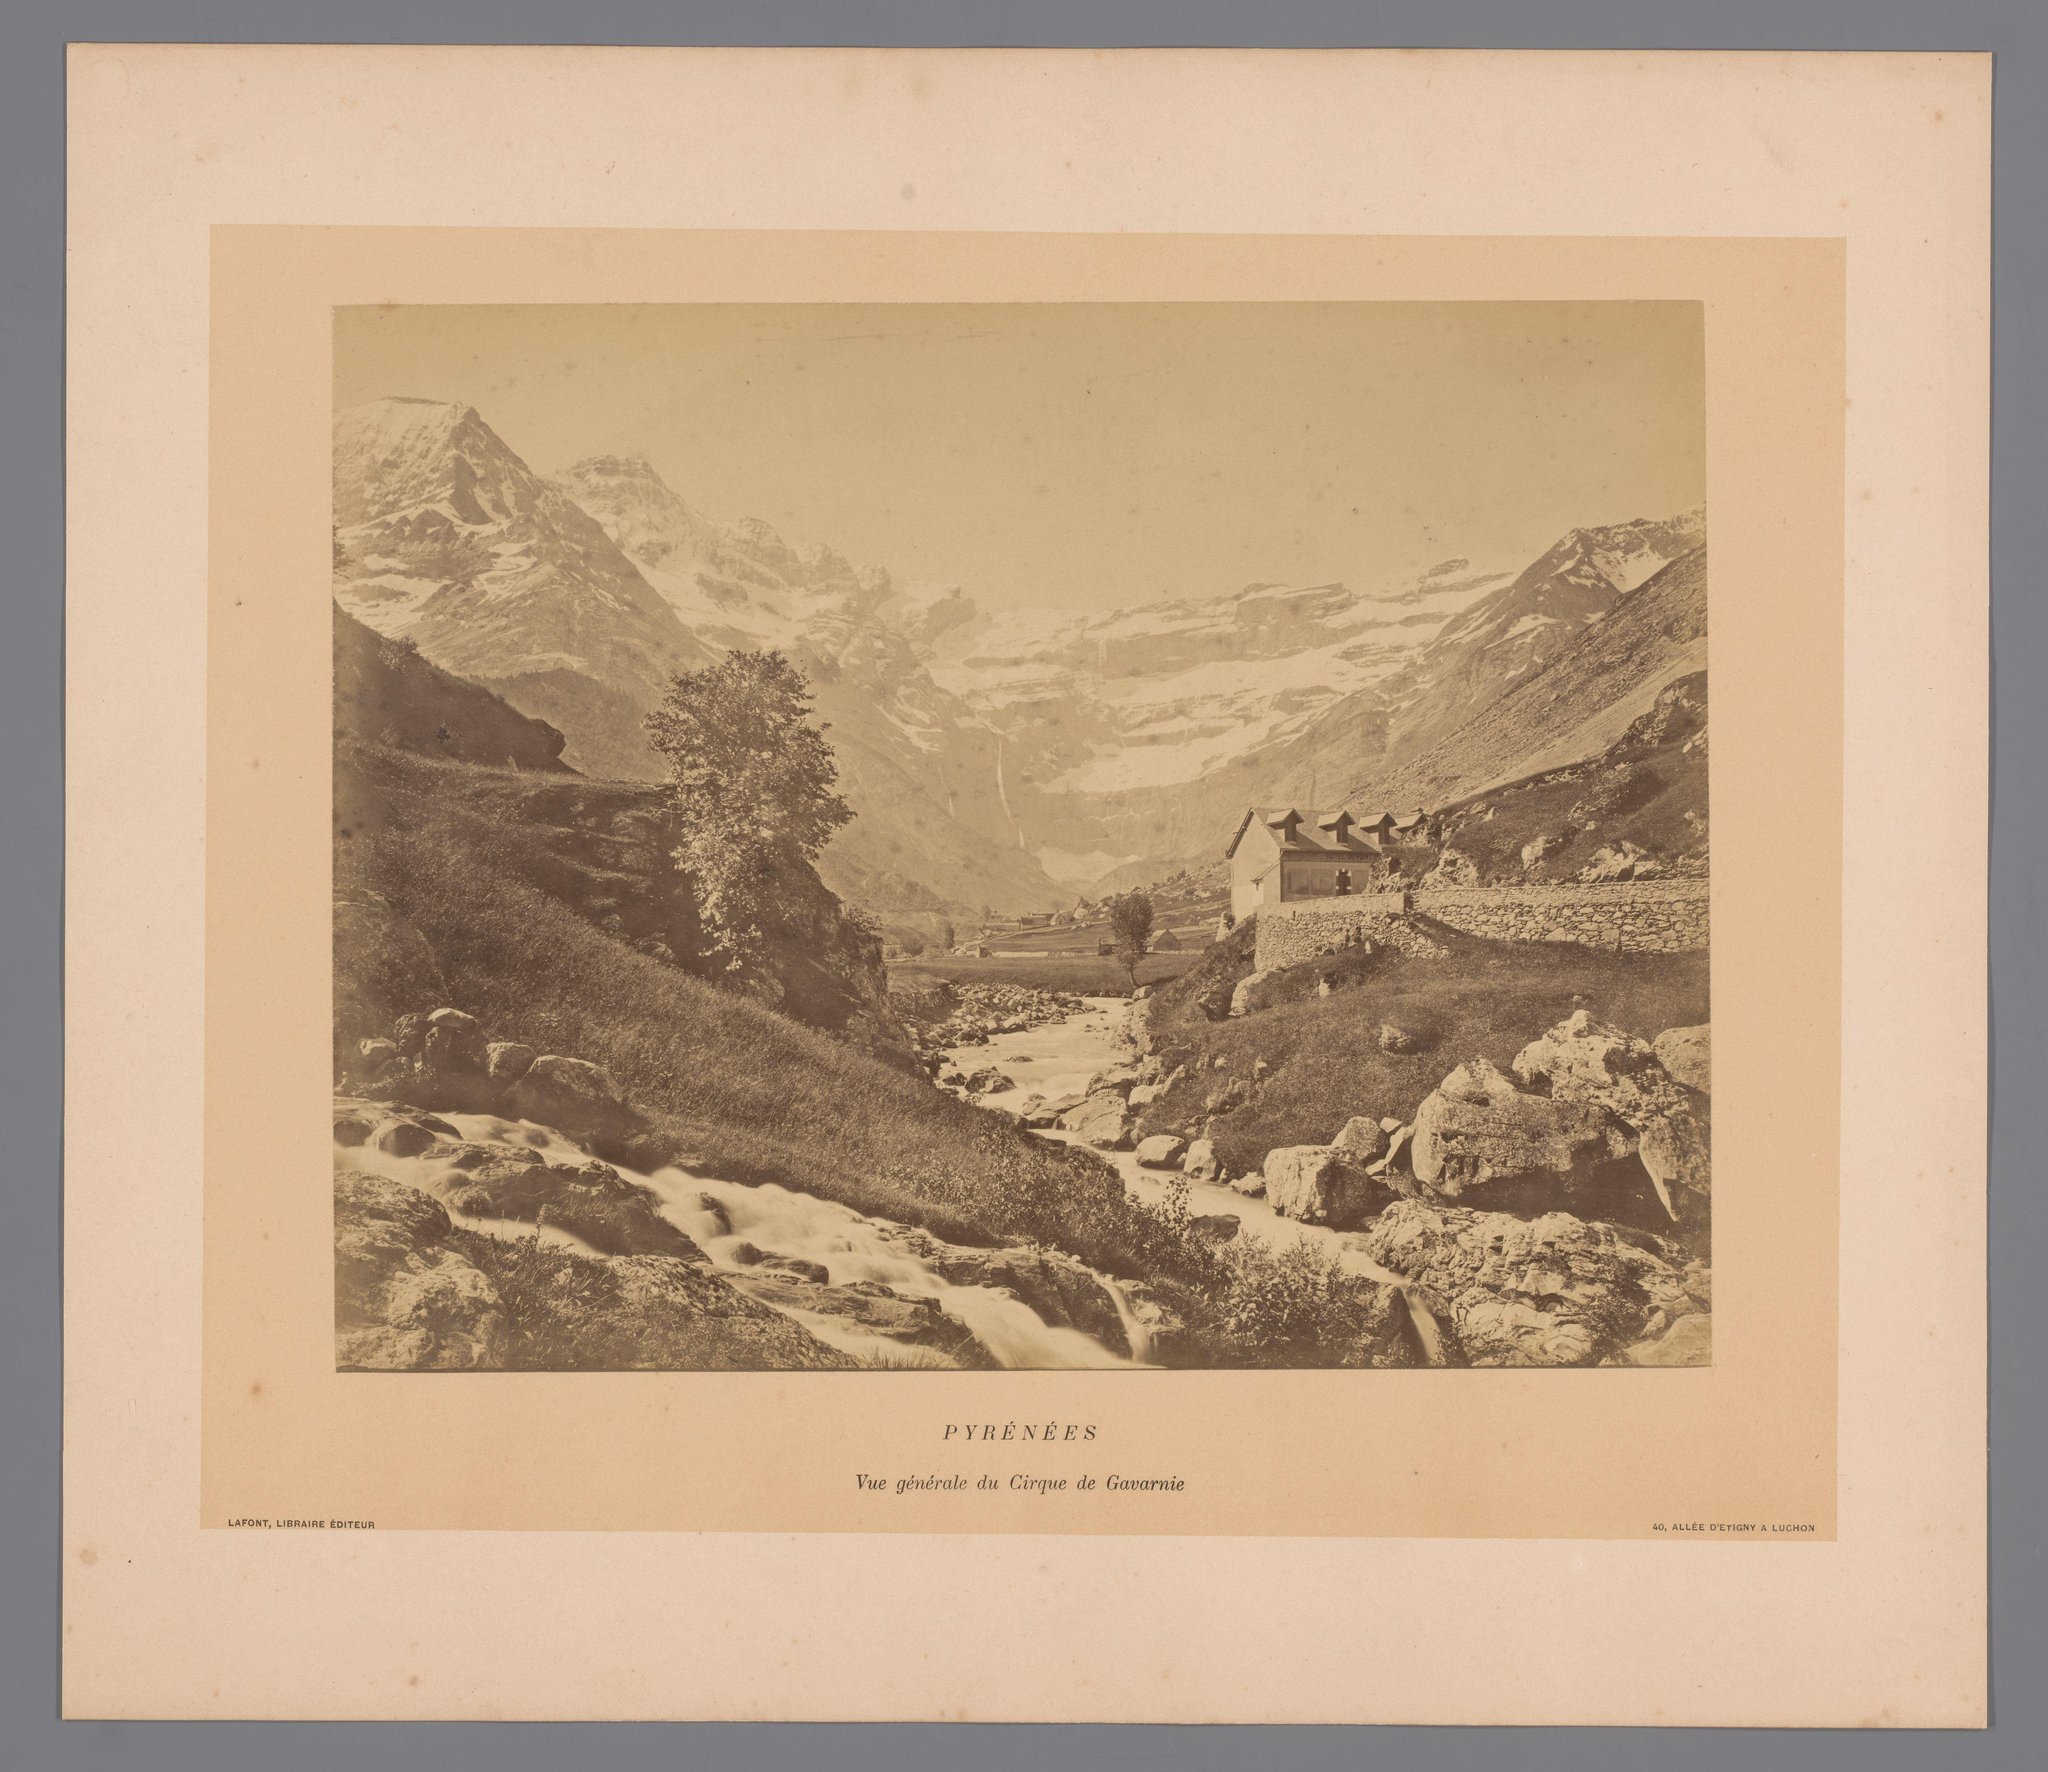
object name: photograph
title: "PYRÉNÉES//Vue générale du Cirque de Gavarnie", Pyréneeën, Frankrijk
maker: Anonymous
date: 1884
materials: cardboard, paper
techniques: albumen print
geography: luchon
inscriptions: date: ‘12 October 1884.’, caption: ‘LAFONT, LIBRAIRE ÉDITEUR//40, ALLÉE D'ETIGNY A LUCHON’, caption: ‘PYRÉNÉES//Vue générale du Cirque de Gavarnie’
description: Gezicht vanuit een vallei op een beek/rivier, met een huis en besneeuwde bergtoppen op de achtergrond.